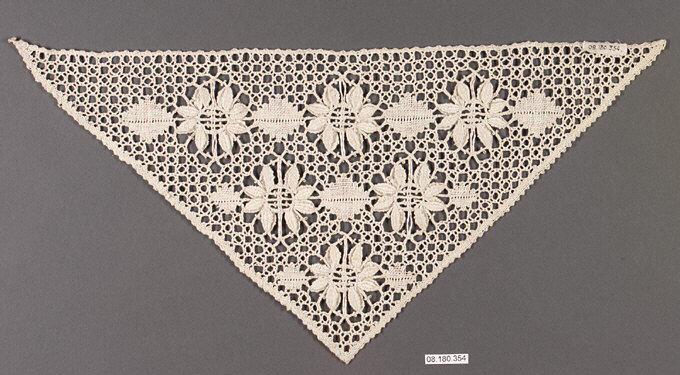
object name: piece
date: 1801-1900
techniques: lace